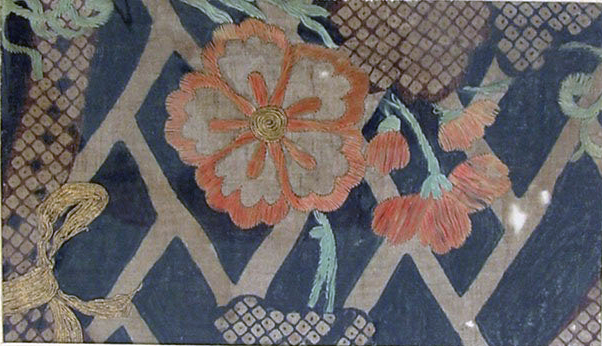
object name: piece from a summer kosode katabira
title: Piece from a Summer Kosode (katabira) with Flowering Vine and Cypress Fence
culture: japanese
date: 1615-1868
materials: fiber, metal thread, silk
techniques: dyeing, embroidery, weave, resist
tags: flowers